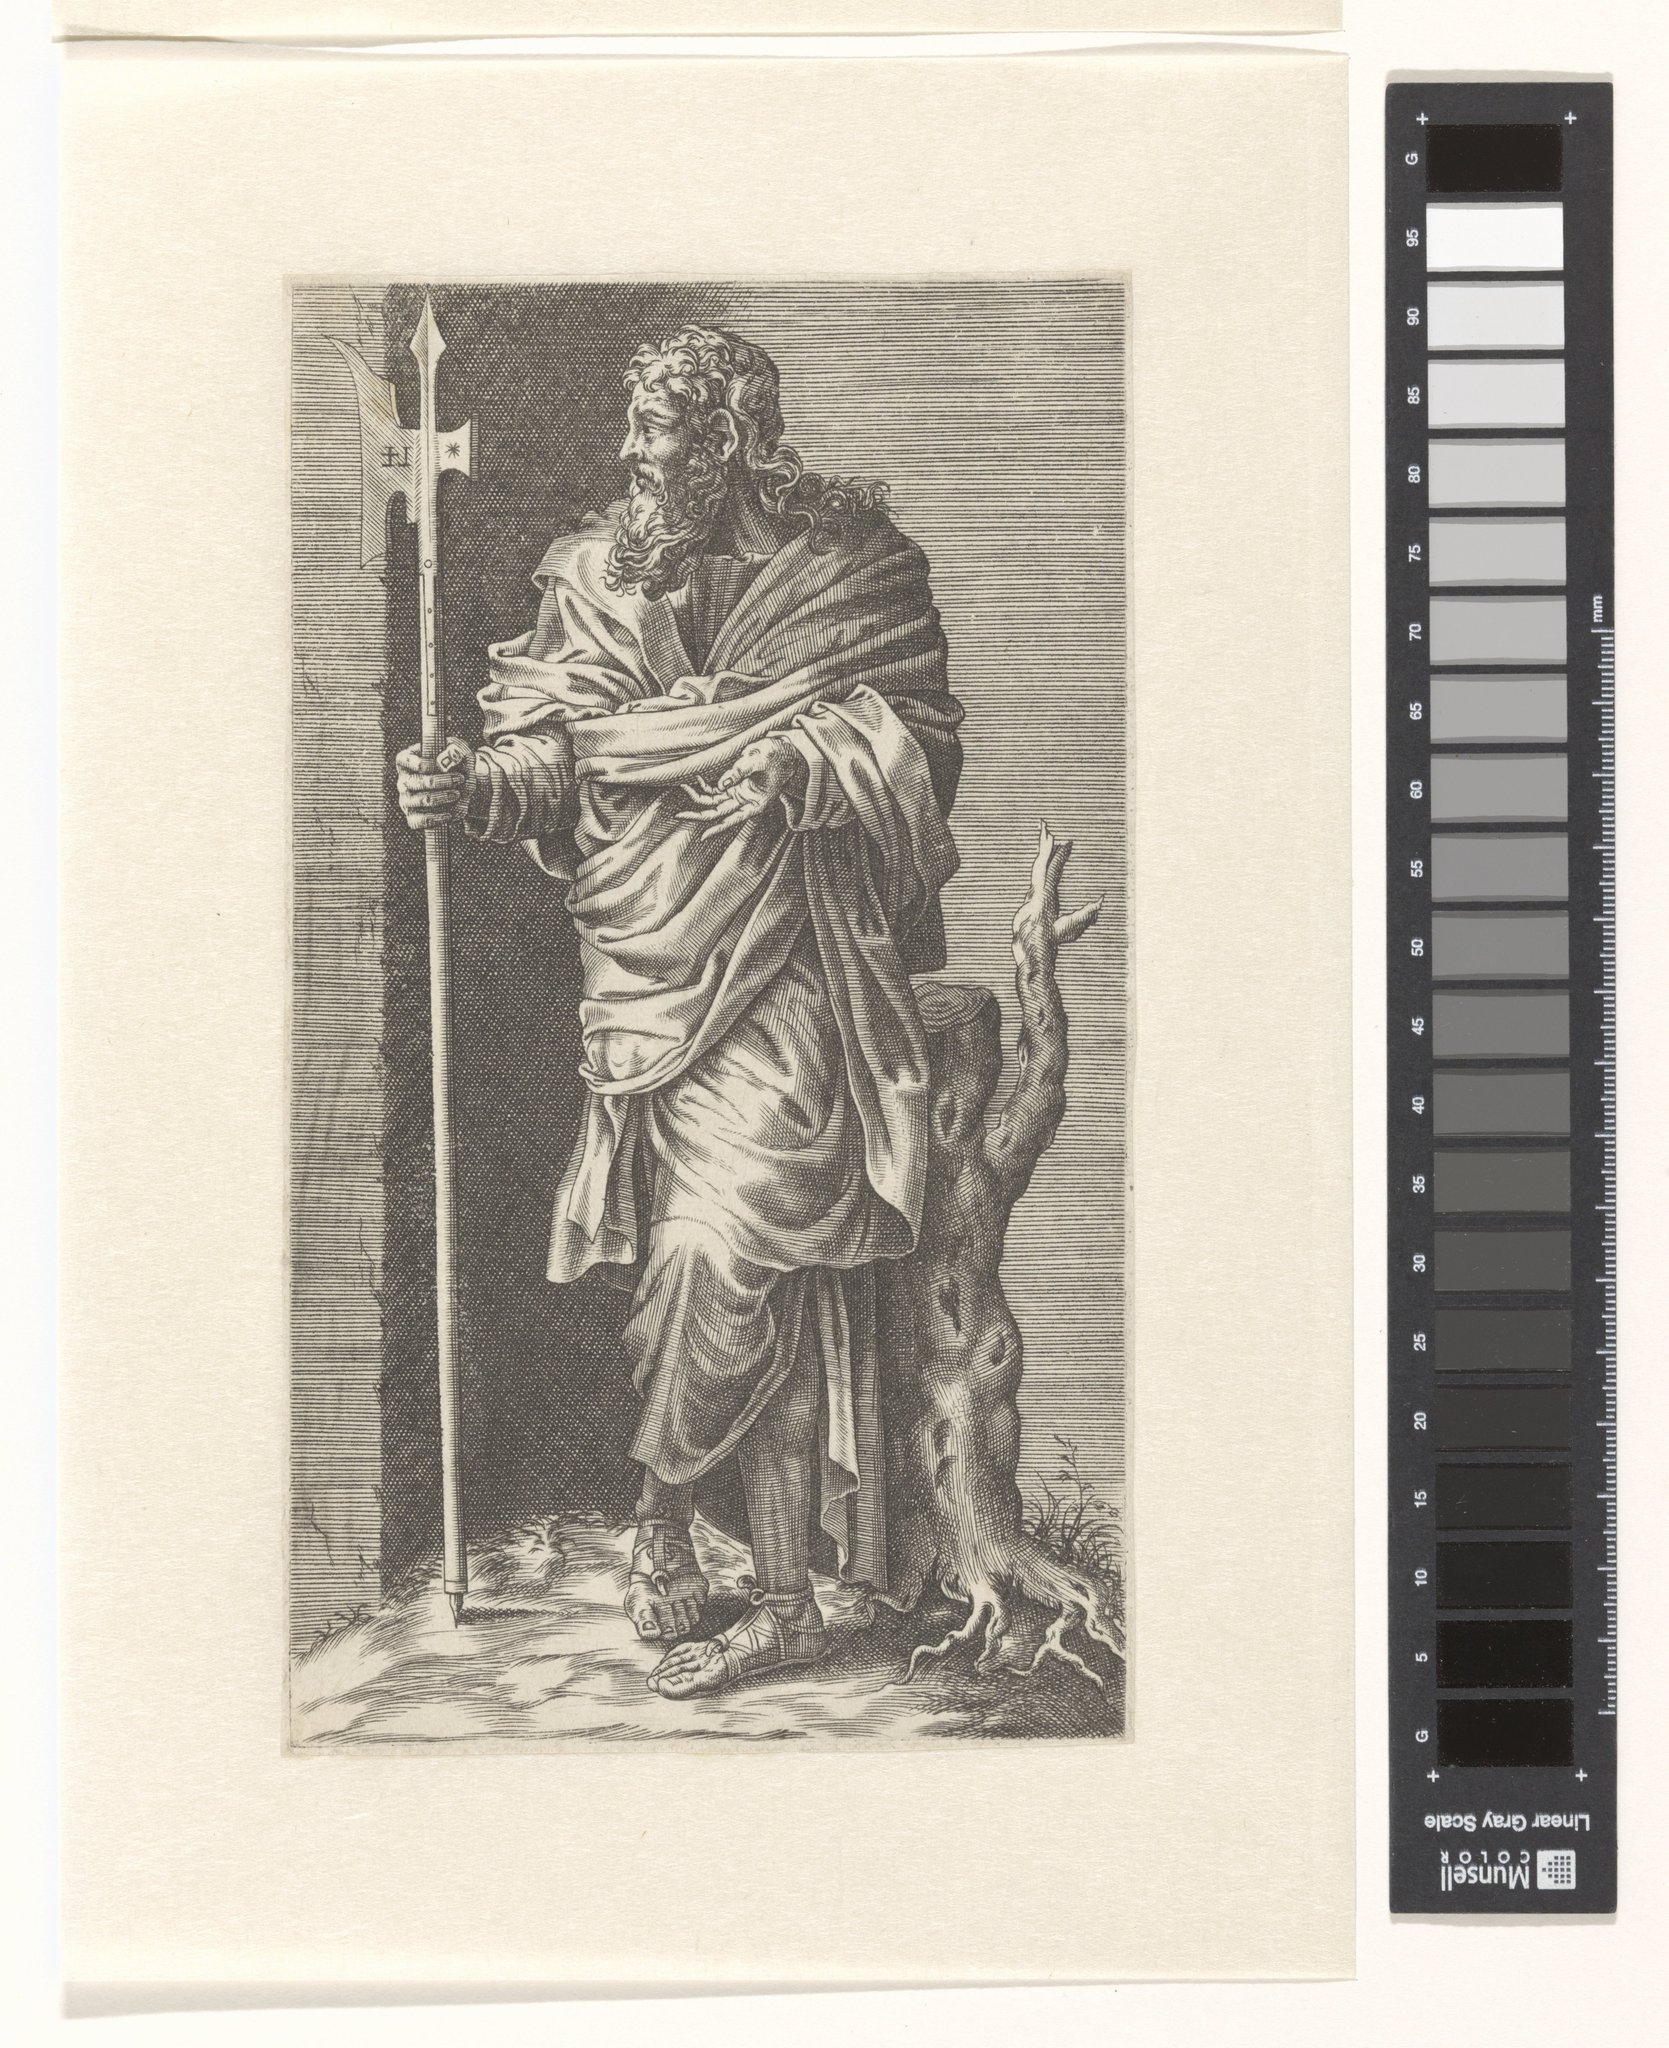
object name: print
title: Christus en twaalf apostelen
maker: Anonymous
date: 1555-1565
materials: paper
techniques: engraving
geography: netherlands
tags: the apostle thomas; possible attributes: book, chalice, girdle, heart, lance or spear, scroll, square, stones, adult christ together with apostles, evangelists, saints, etc., the twelve apostles (as a group), usually with books or scrolls (not in biblical context)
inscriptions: collector's mark: Lugt 2228, collector's mark: Lugt 2760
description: Slechts één andere, complete serie bekend: in de Koninklijke Bibliotheek te Brussel. Proefdrukken, vóór de opschriften van de namen van Christus en de apostelen.